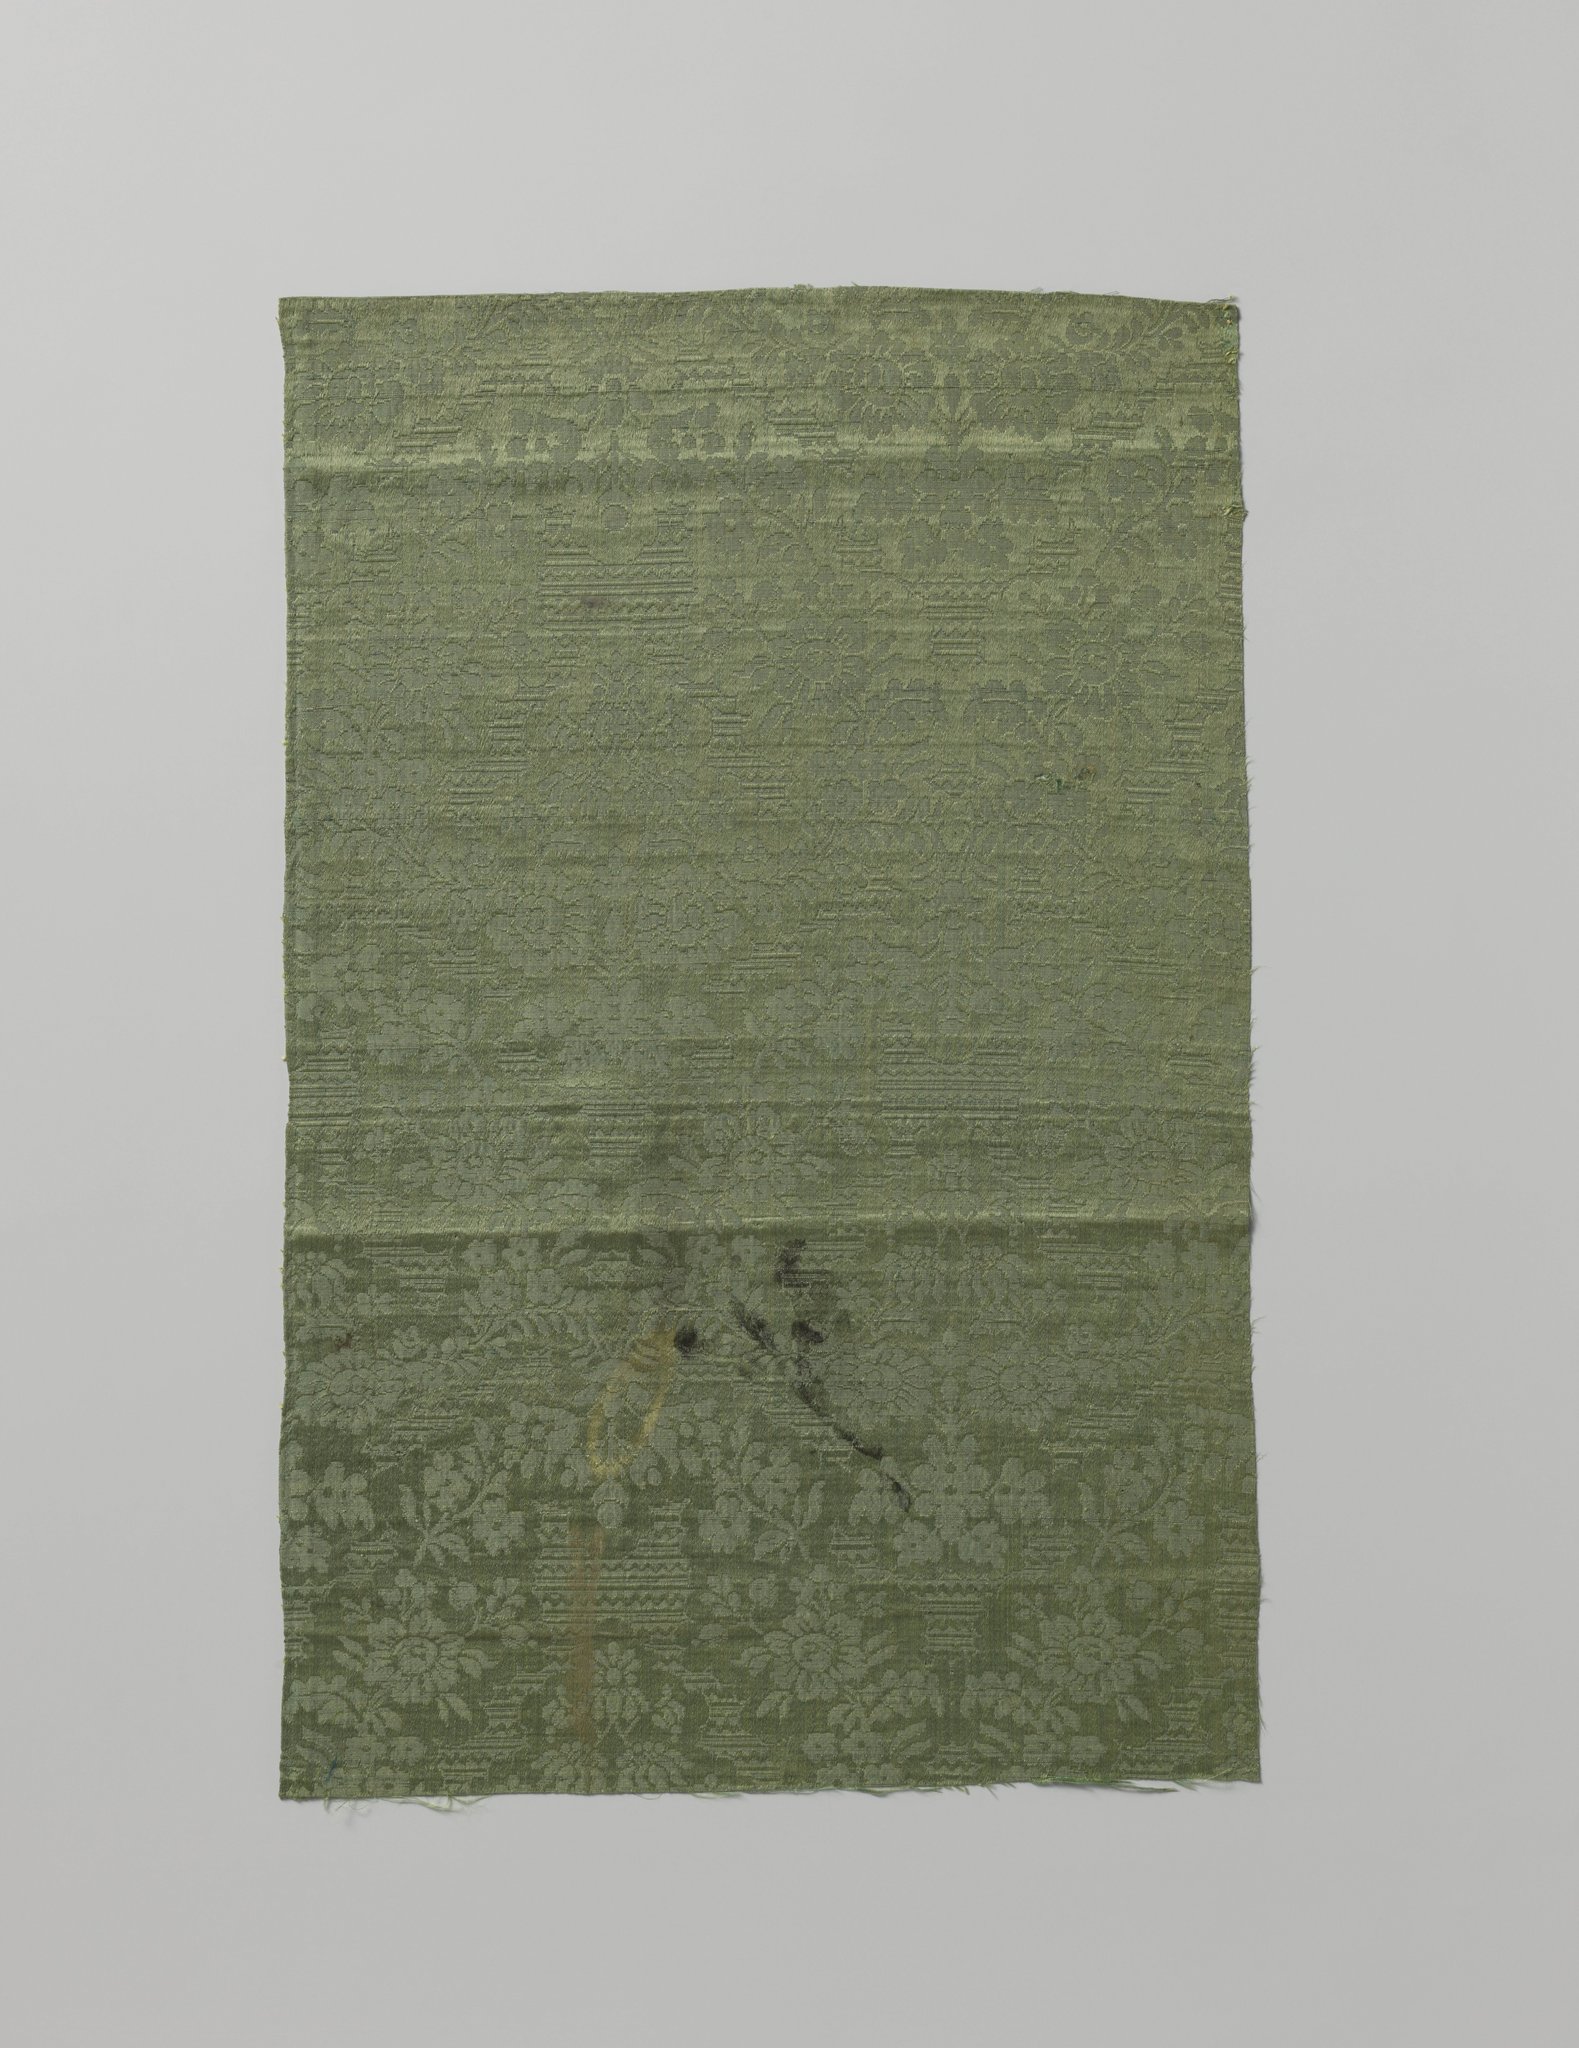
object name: zijdedamast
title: Fragment groen zijdedamast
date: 1750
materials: silk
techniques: damask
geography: germany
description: Een fragment van groen damast. Het symmetrische patroon heeft bloemtakken en bladeren waartussen pagodeachtige motieven en onregelmatig gestreepte geometrische figuren.